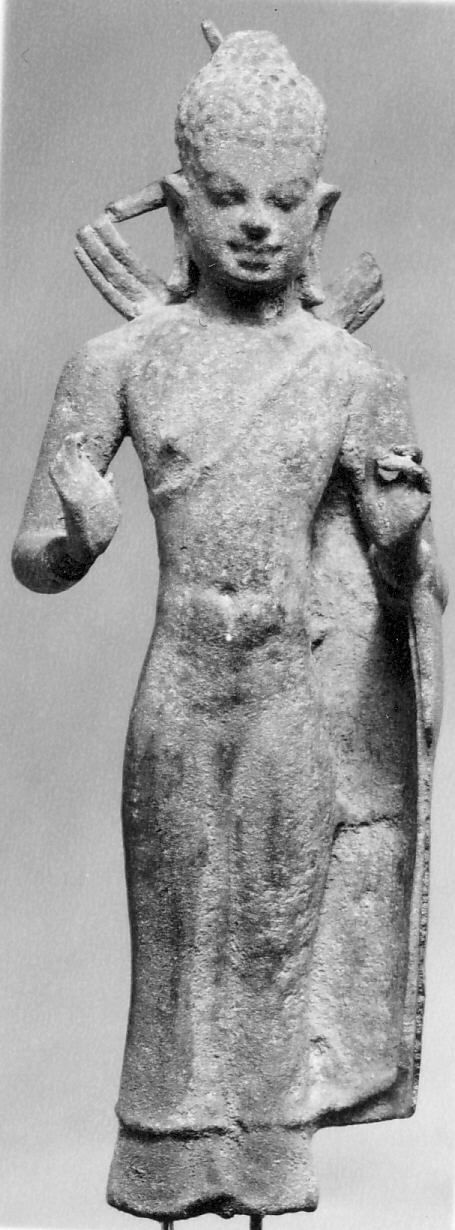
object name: figure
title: Standing Buddha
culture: indonesian, javanese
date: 801-900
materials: bronze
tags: buddhism,buddha